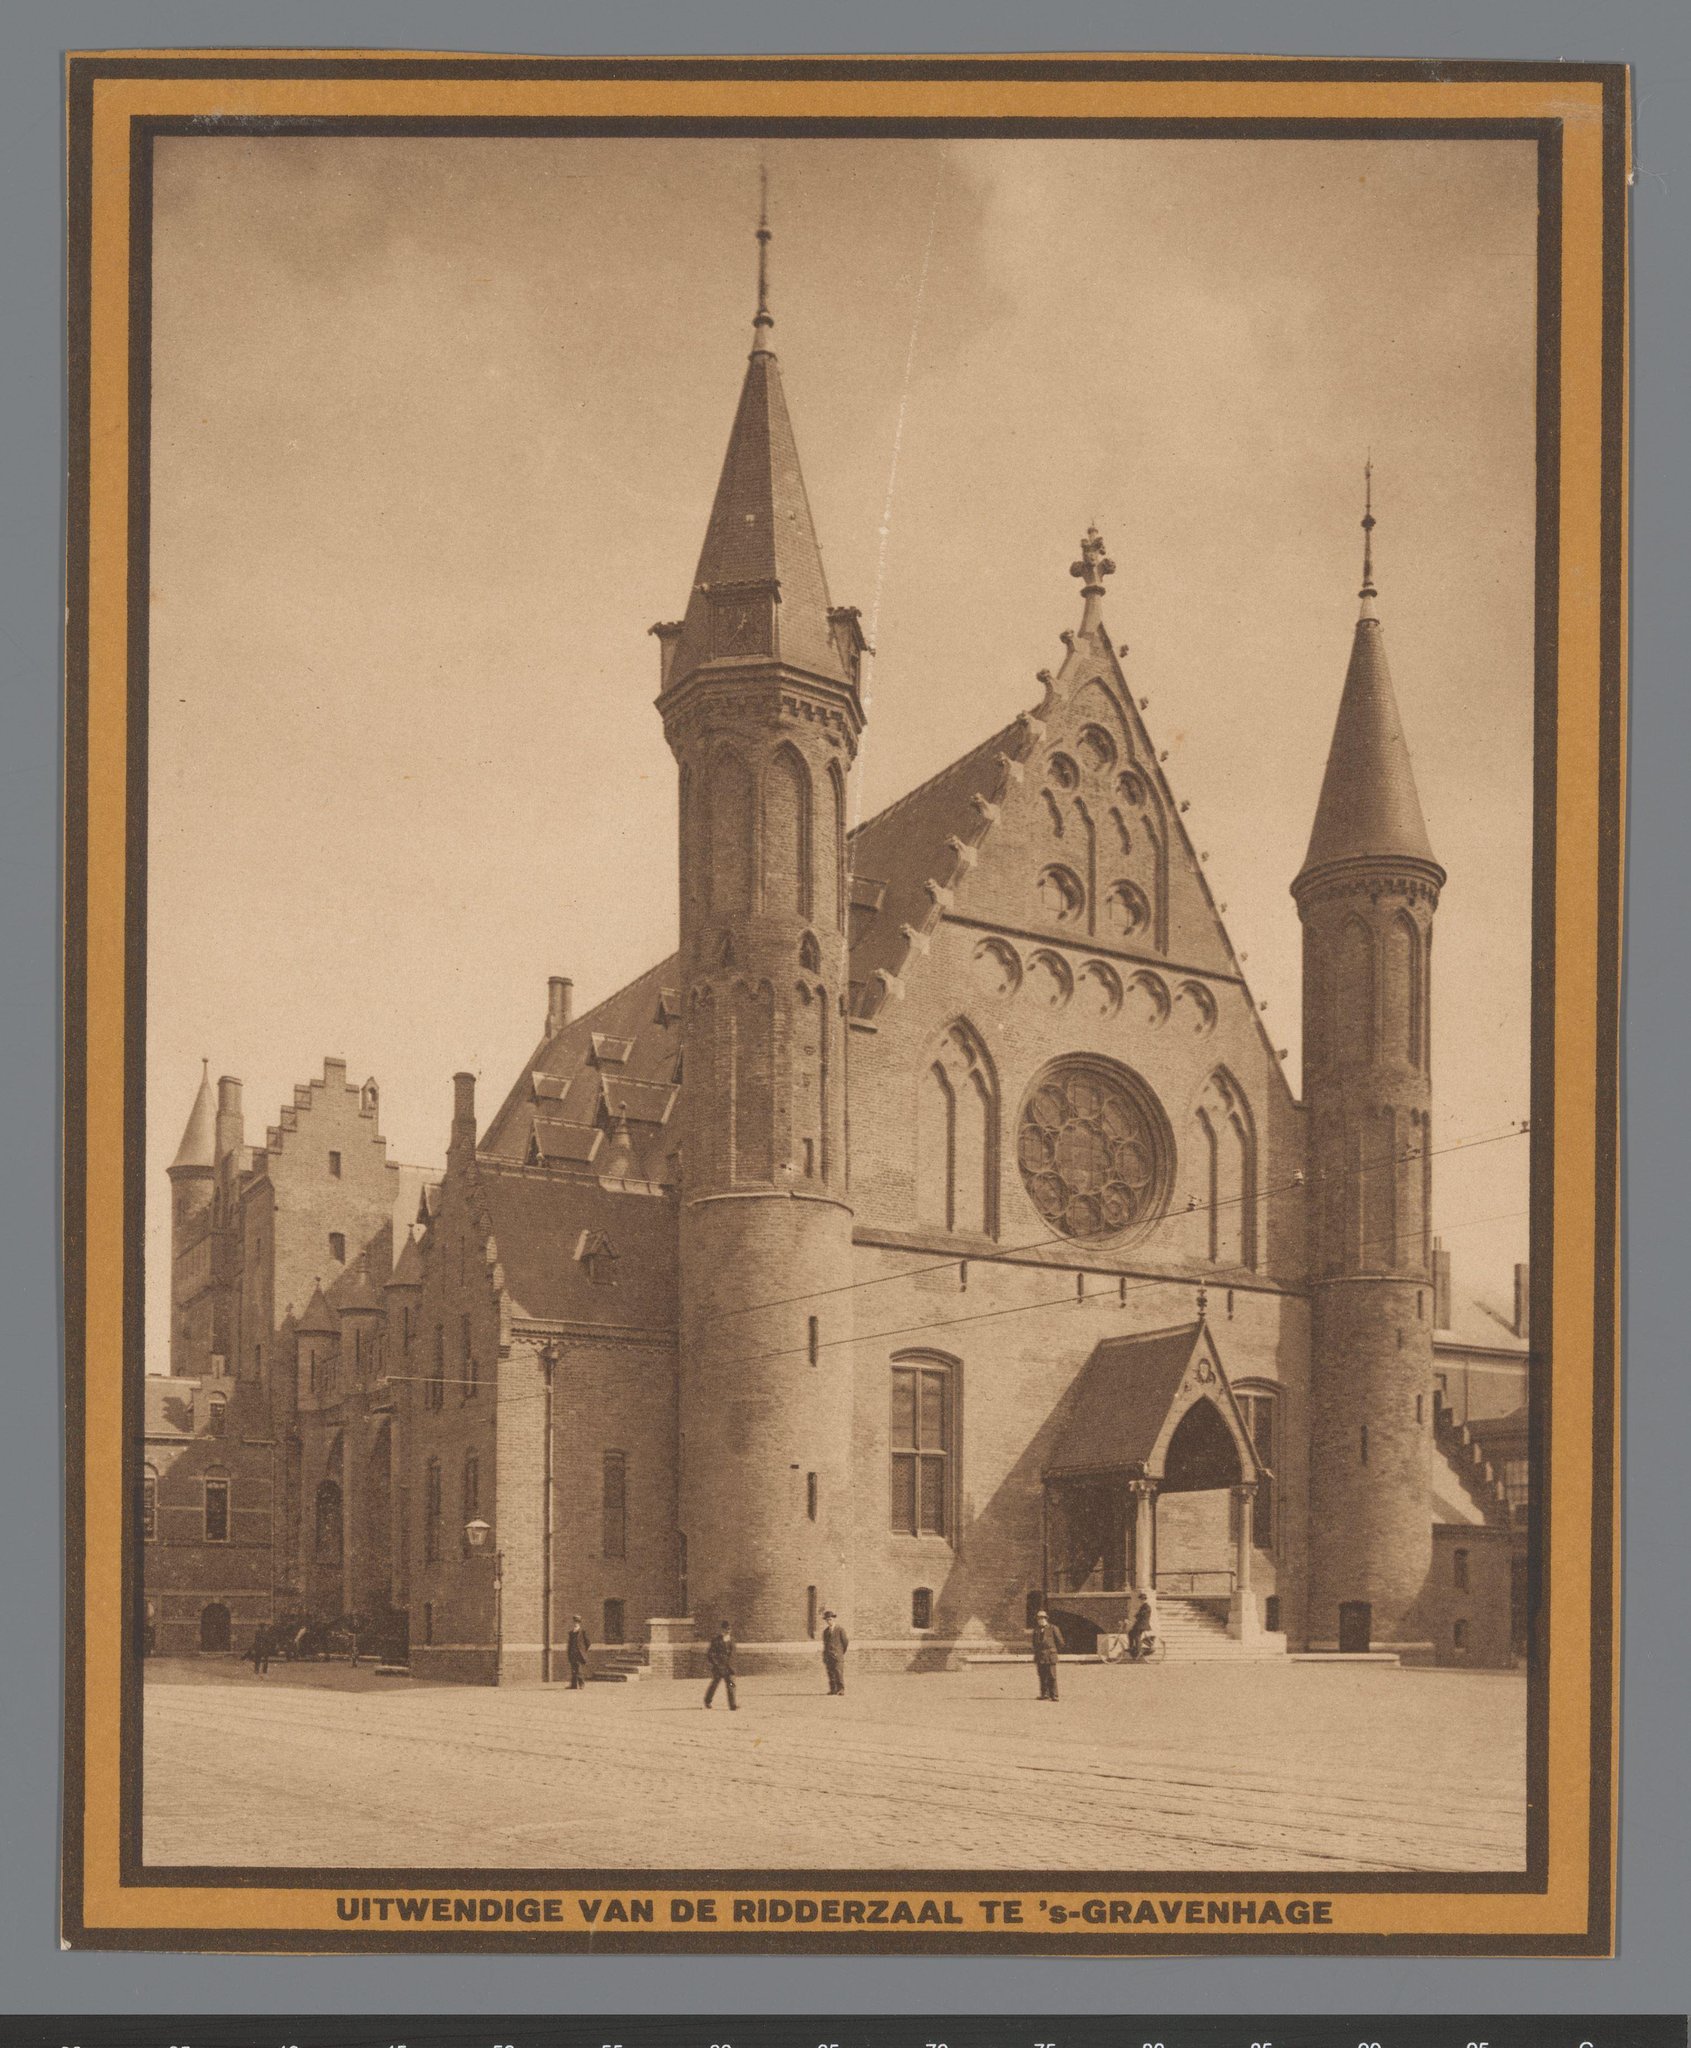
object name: print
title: Het stadhuis te Veere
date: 1747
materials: paper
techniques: etching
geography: amsterdam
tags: townhall, square, place, circus, etc. (+ city(-scape) with figures, staffage)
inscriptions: date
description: Tijdens het maken van de platen is op de plaat van deze prent de verkeerde titel gezet: 'Het stadhuis te Vlissingen'. De juiste titel met het adres van Isaak Tirion is hieroverheen geplakt. Prent ook gebruikt in: Wagenaar, Jan. Tegenwoordige staat der Vereenigde Nederlanden (...). Amsterdam: Isaak Tirion, 1753, dl. 10, tussen p. 168 en 169.